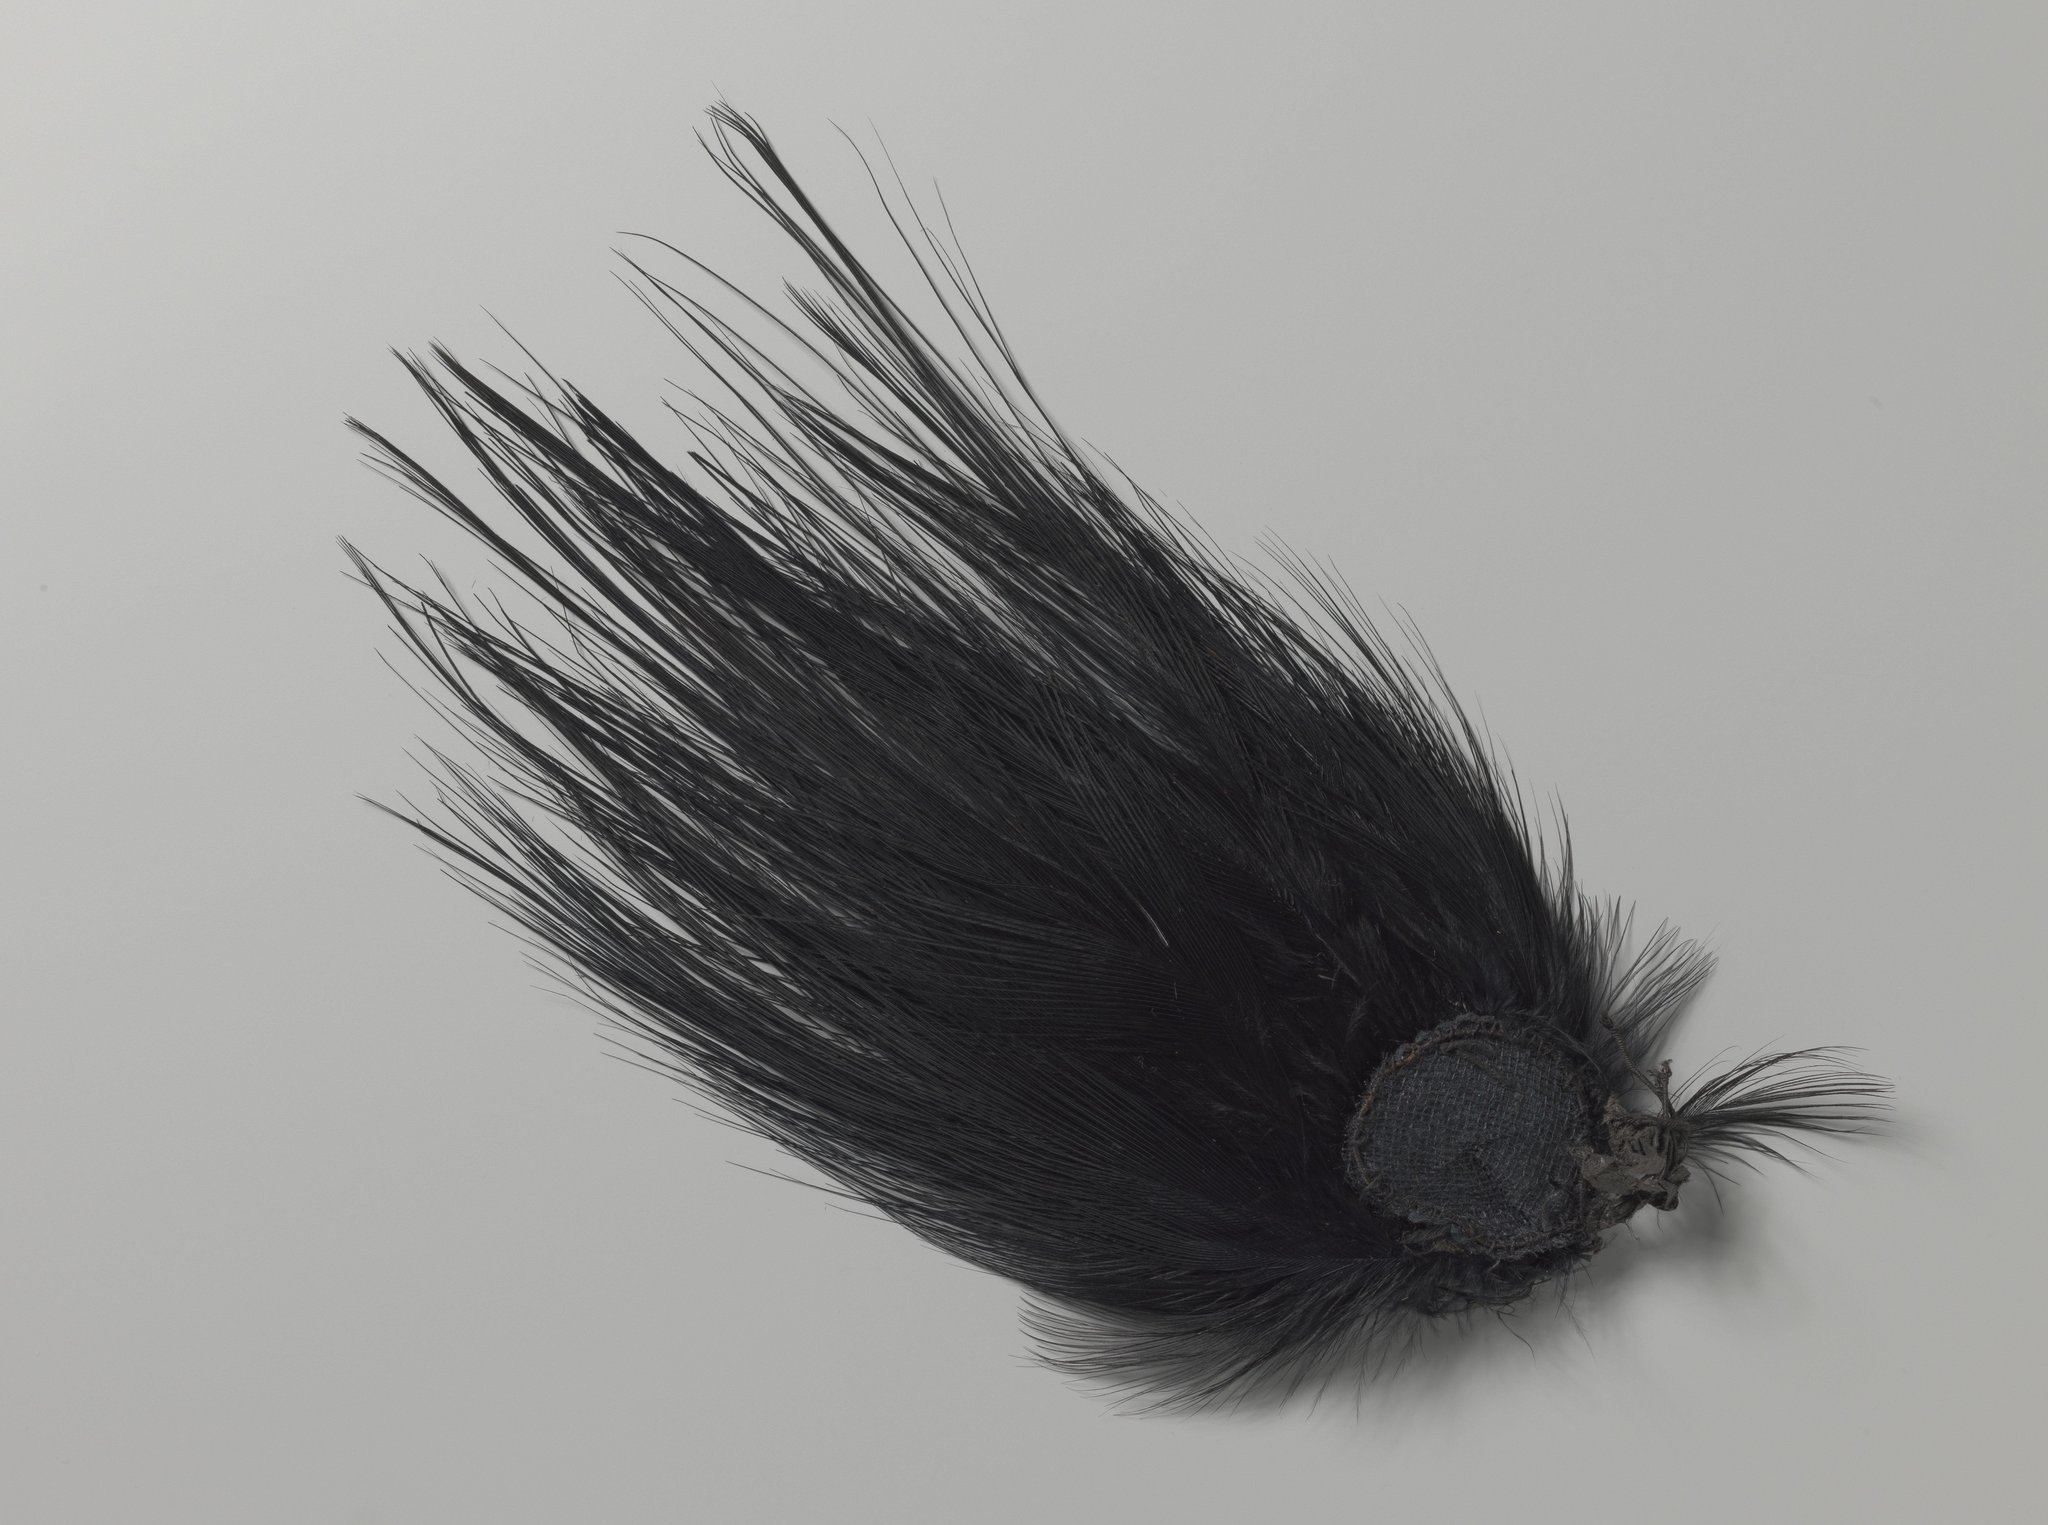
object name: hoedengarneersel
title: Toef van zwarte aigrettes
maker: Anonymous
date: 1880-1950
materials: feather, metal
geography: europe